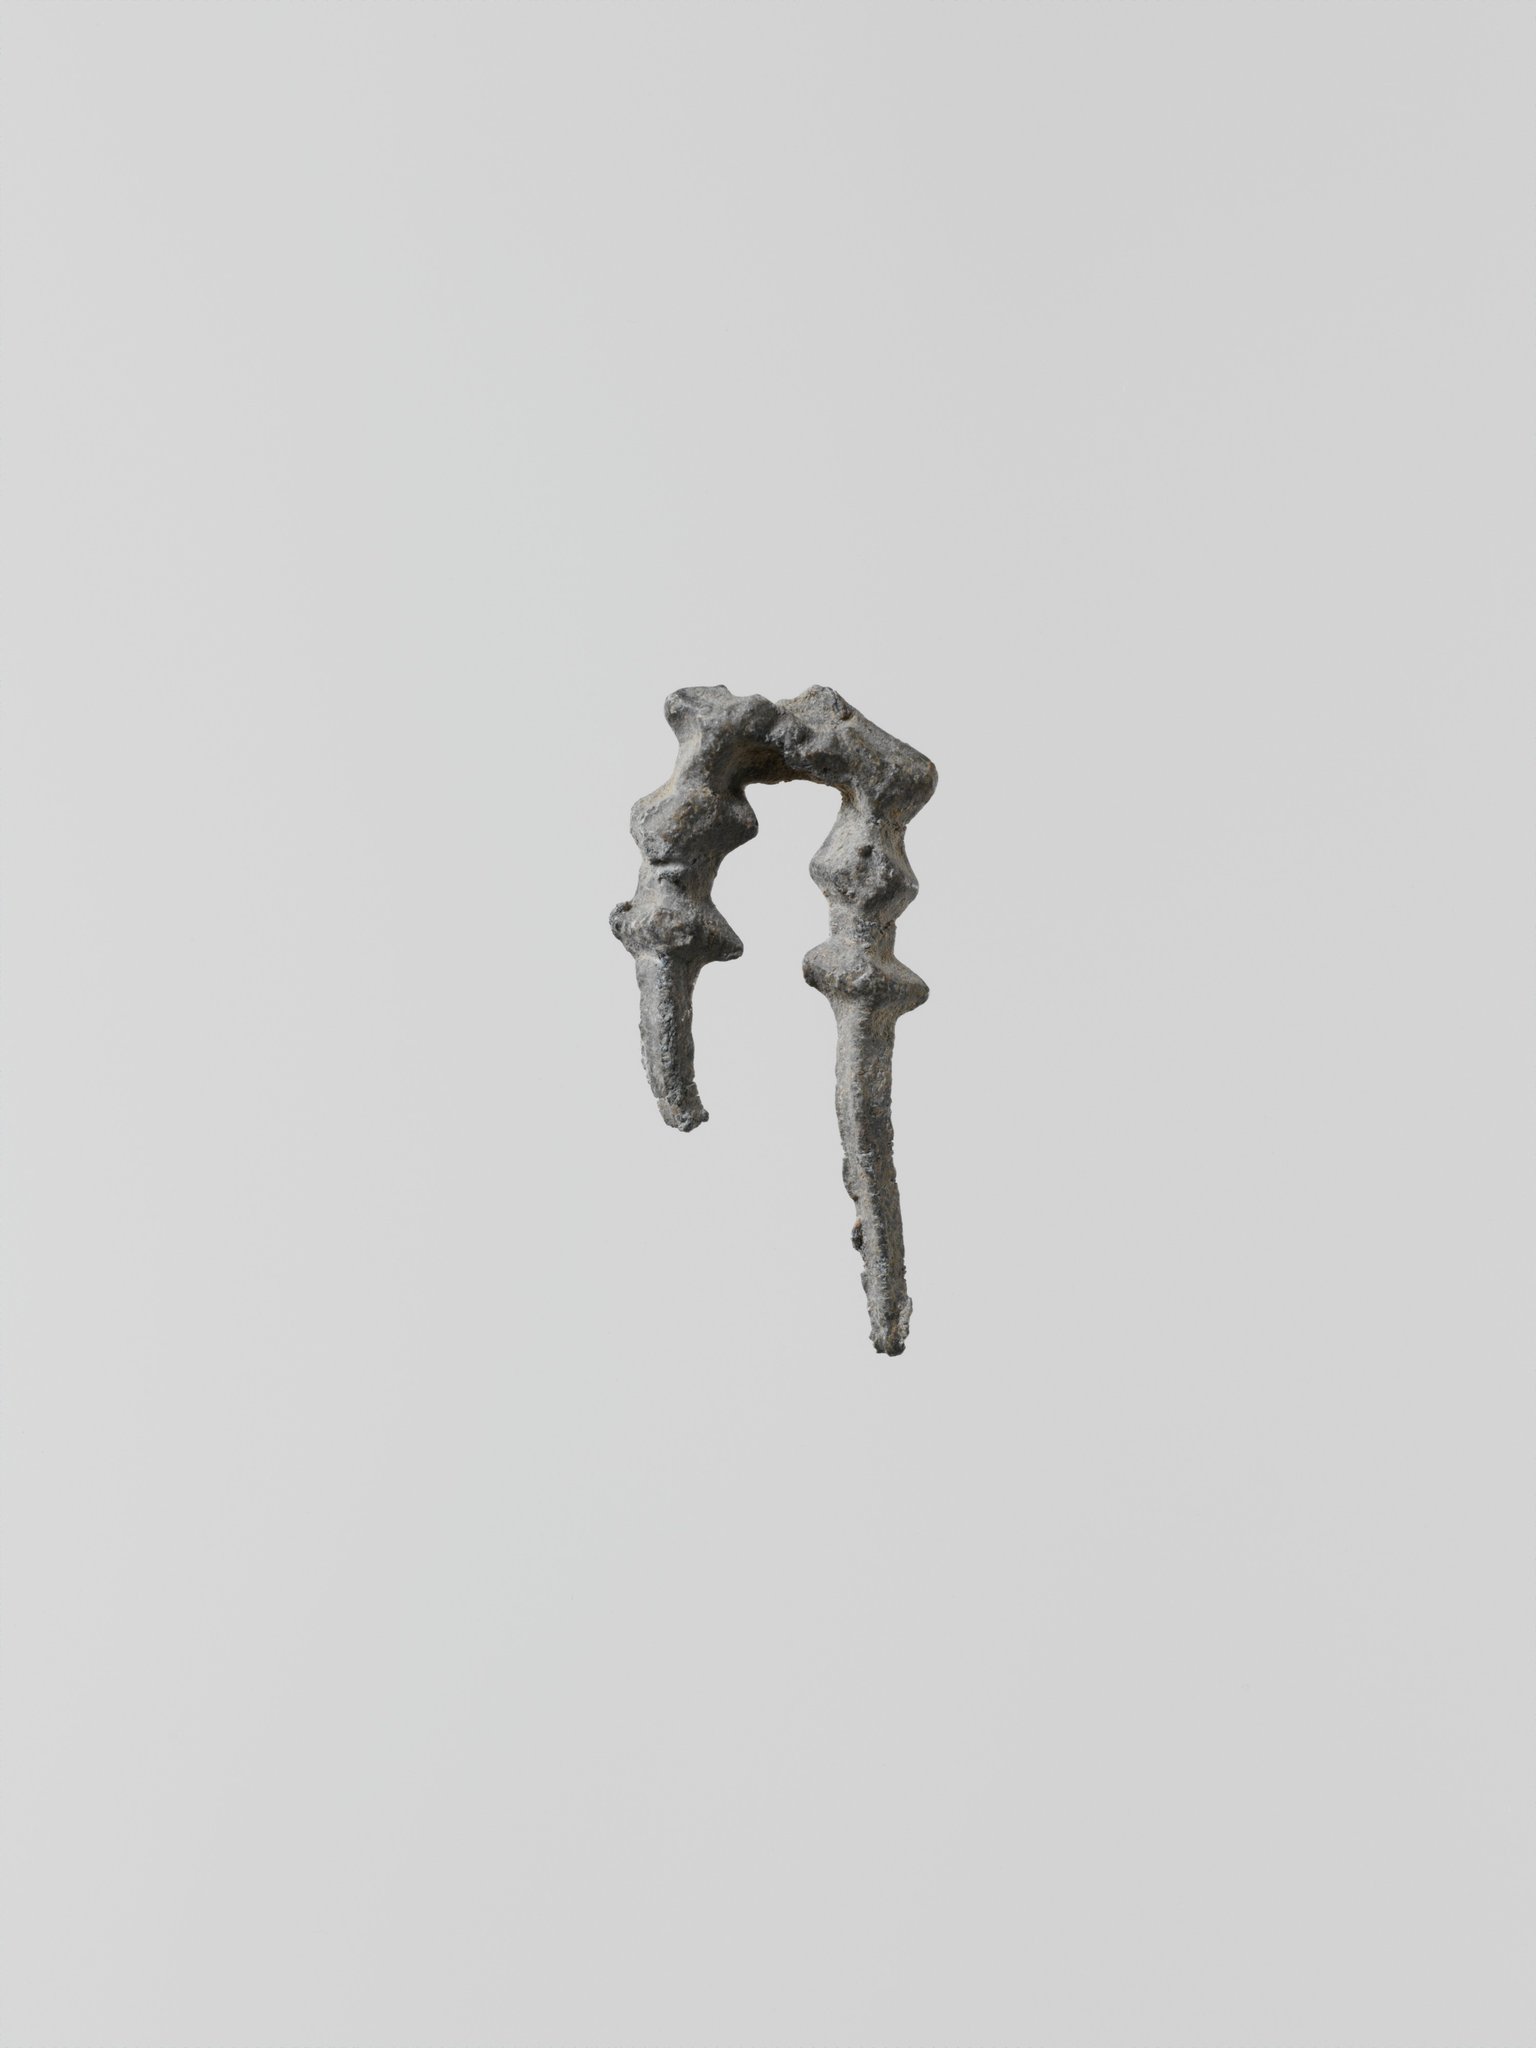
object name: pin, 3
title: Lead ornament, possibly imitating jewelry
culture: greek, laconian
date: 600-401 BCE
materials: lead